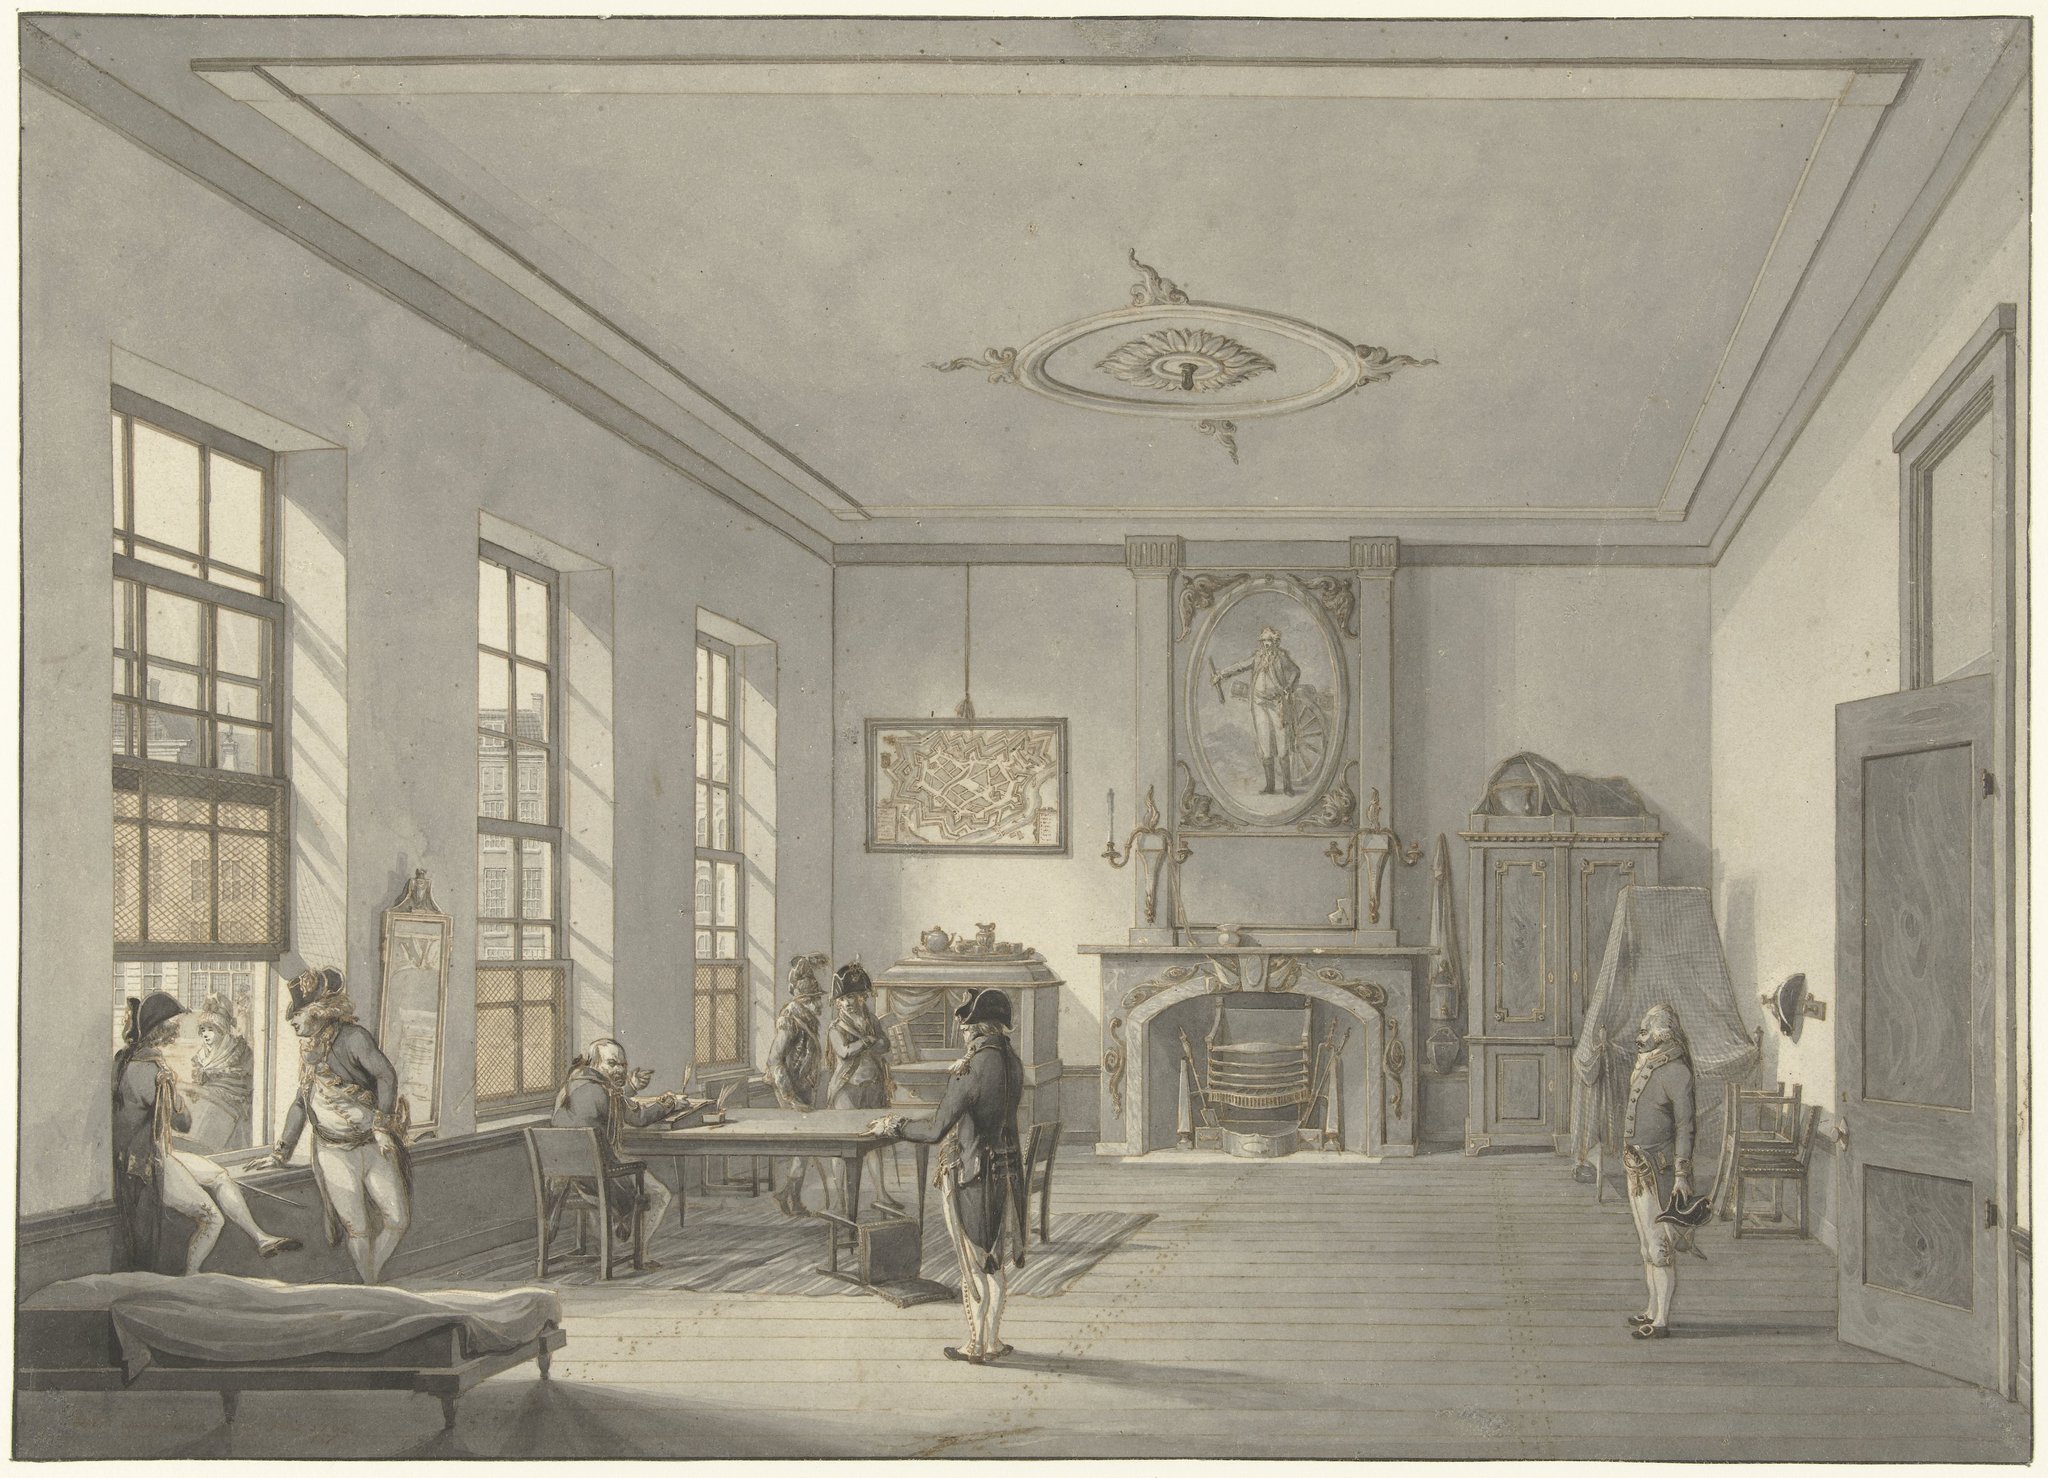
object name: drawing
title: Wachtlokaal voor officieren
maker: dirk langendijk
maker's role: draughtsman, painter, print maker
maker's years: 1748-1805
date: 1795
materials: ink, paper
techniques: brush, pen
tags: the soldier off duty